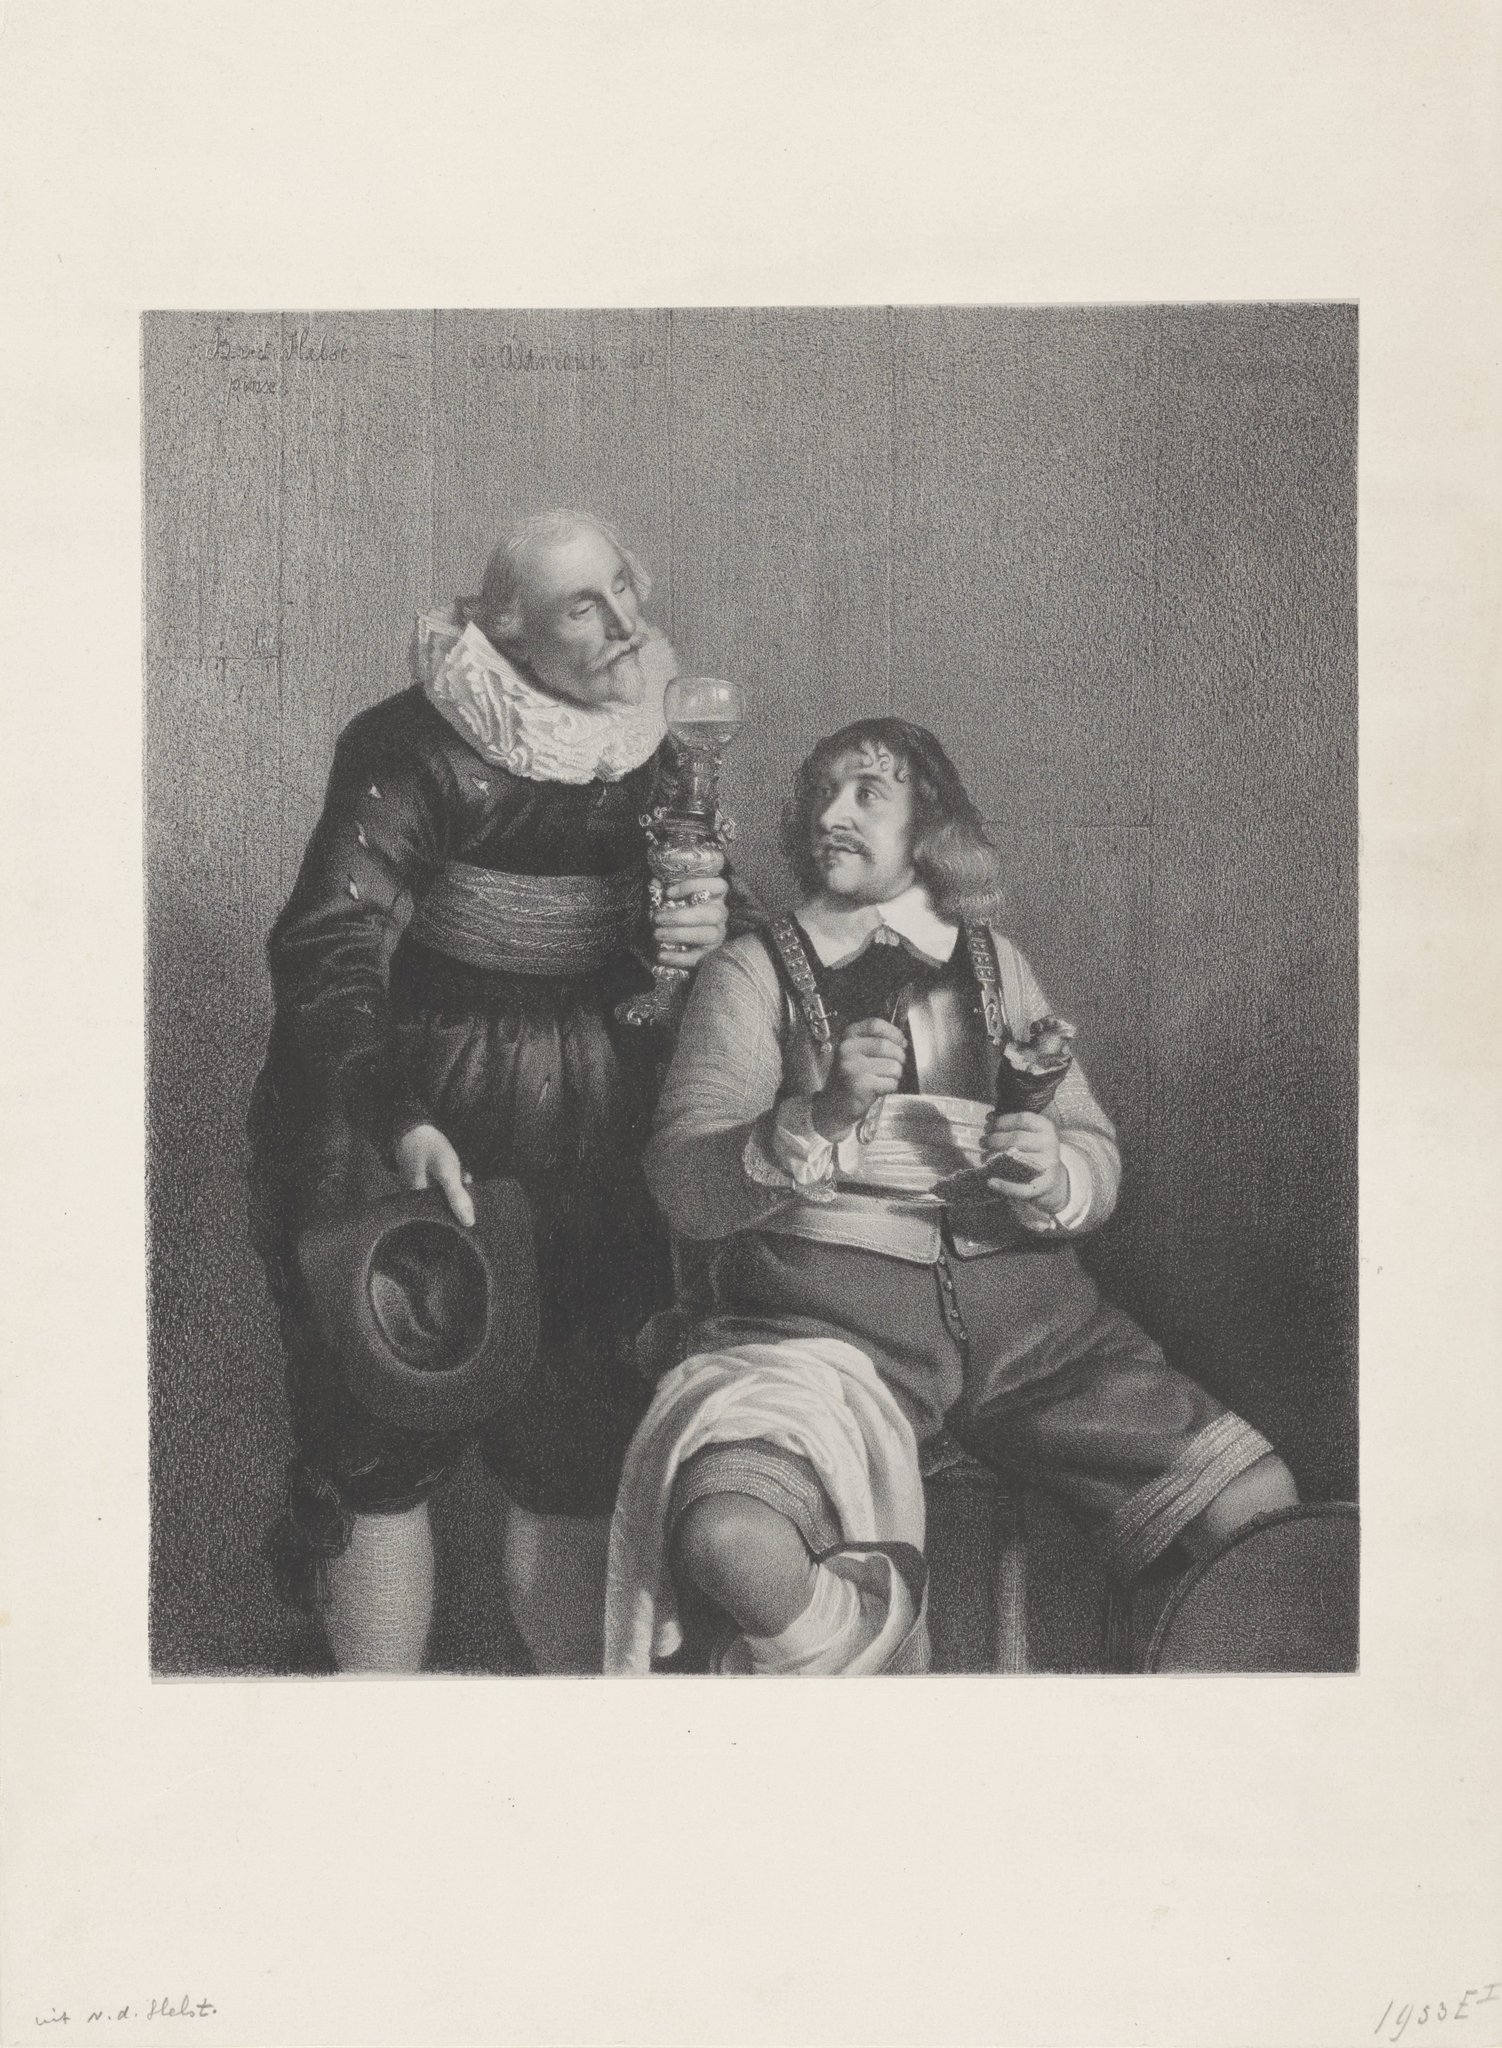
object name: print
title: Twee schutters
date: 1832-1890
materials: paper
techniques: lithograph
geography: netherlands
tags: eating and drinking, anonymous historical persons portrayed in a double portrait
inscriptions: collector's mark: Lugt 2228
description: De zittende man heeft in zijn linkerhand een stuk vlees en brood. In zijn andere hand heeft hij een mes. Hij kijkt op naar een man achter hem met een drinkbeker. De mannen dragen zeventiende-eeuwse kleding.